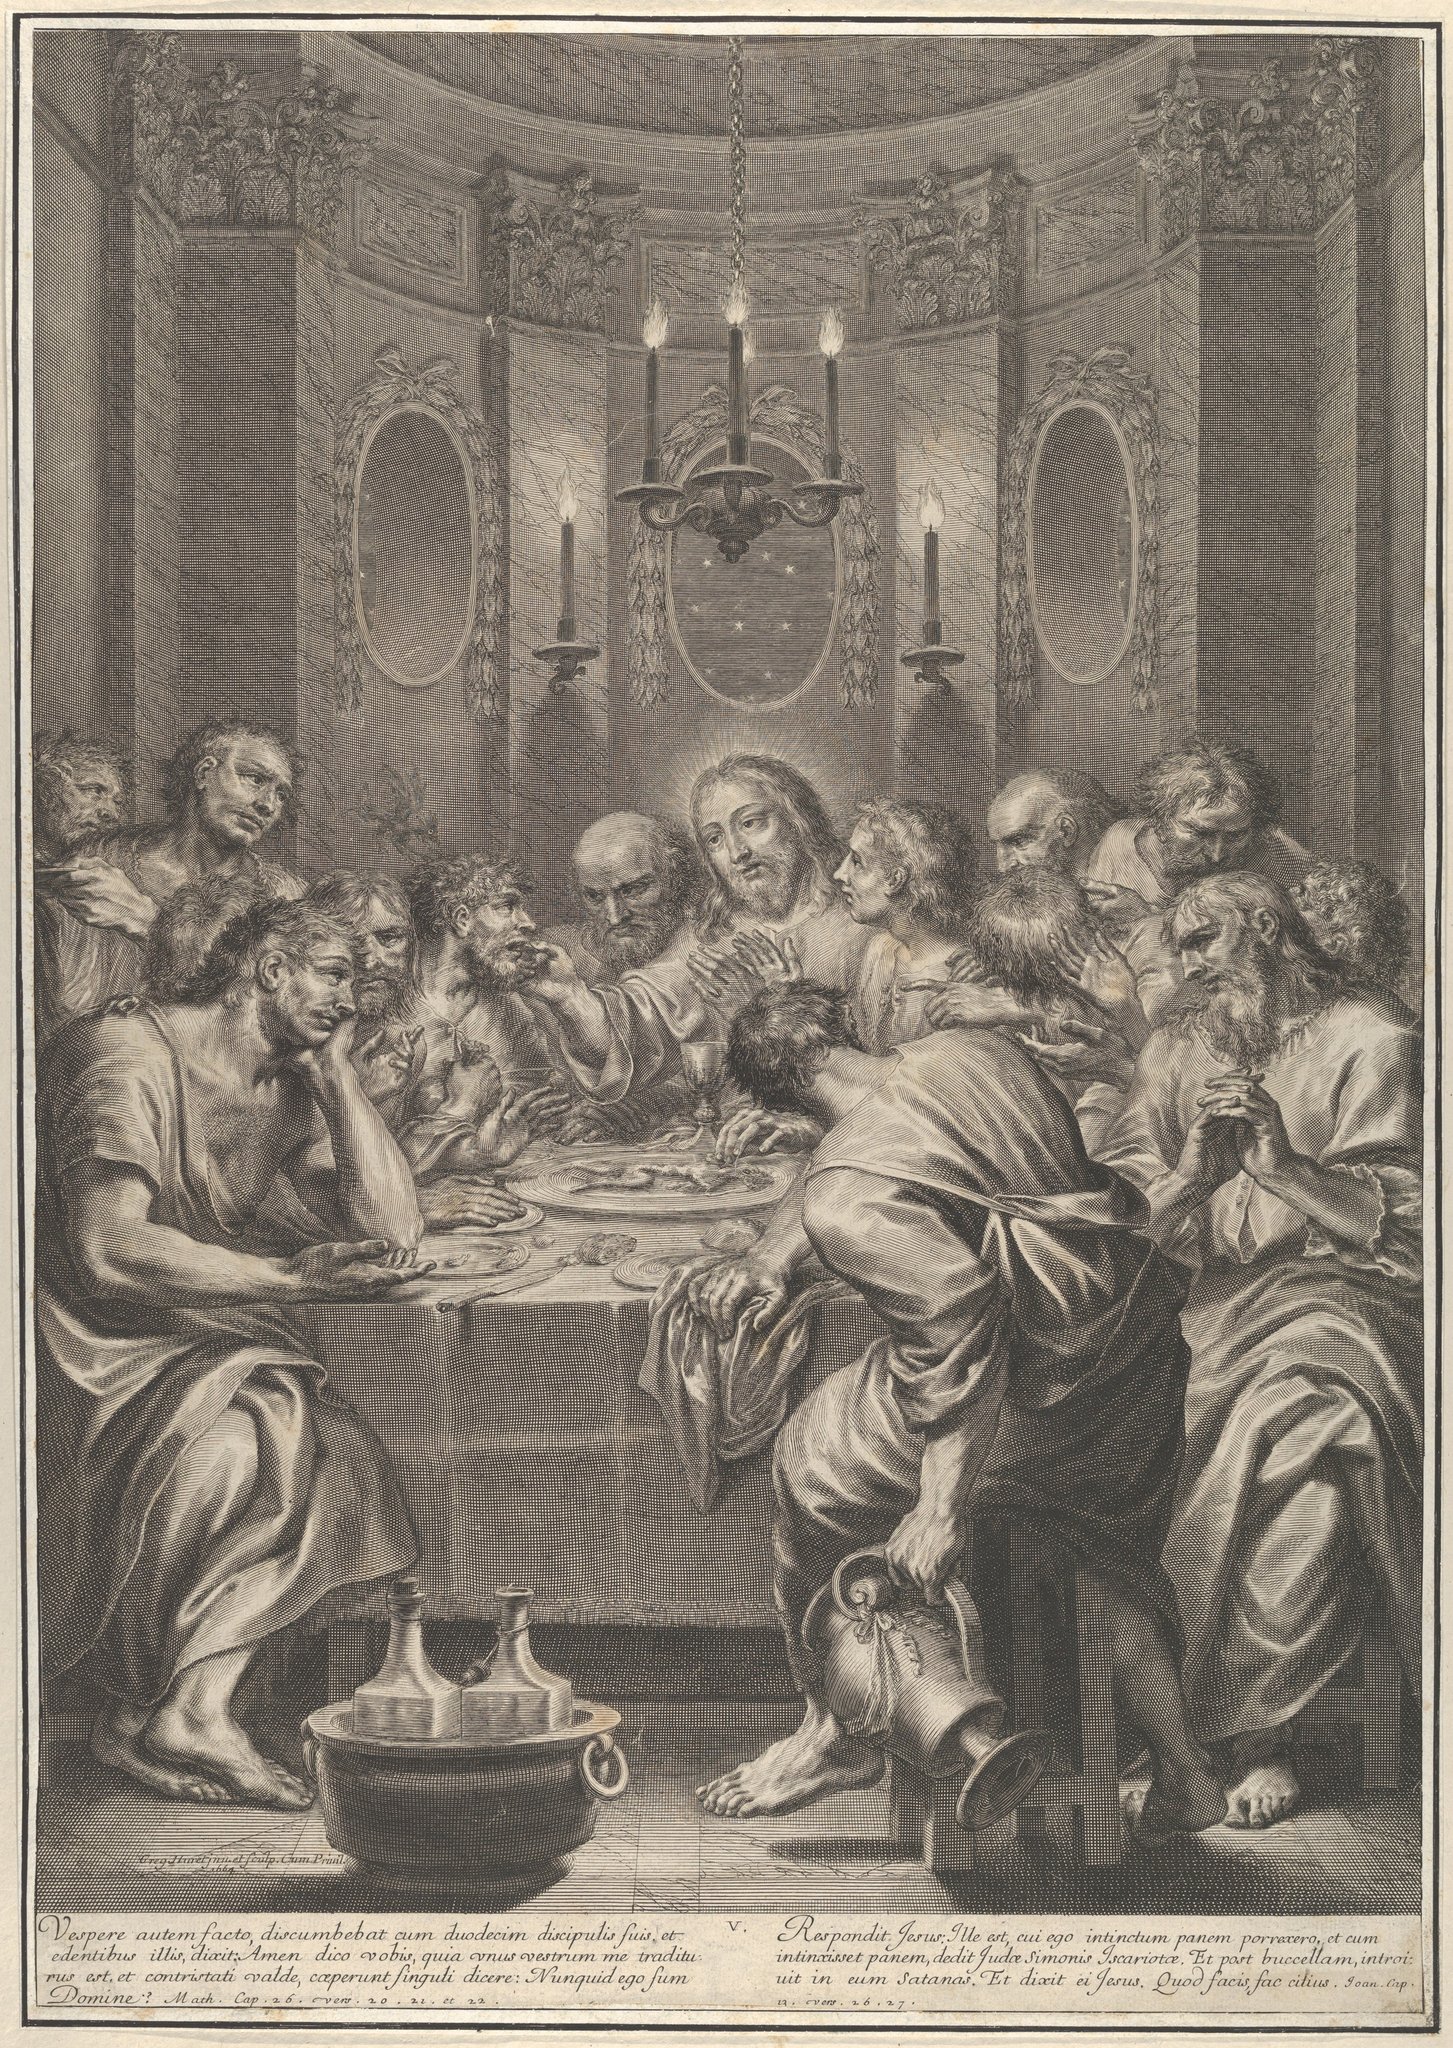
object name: print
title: The Last Supper, from The Passion of Christ, plate 5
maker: grégoire huret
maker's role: artist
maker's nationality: french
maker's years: 1606-1670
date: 1664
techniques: engraving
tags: apostles,christ,last supper